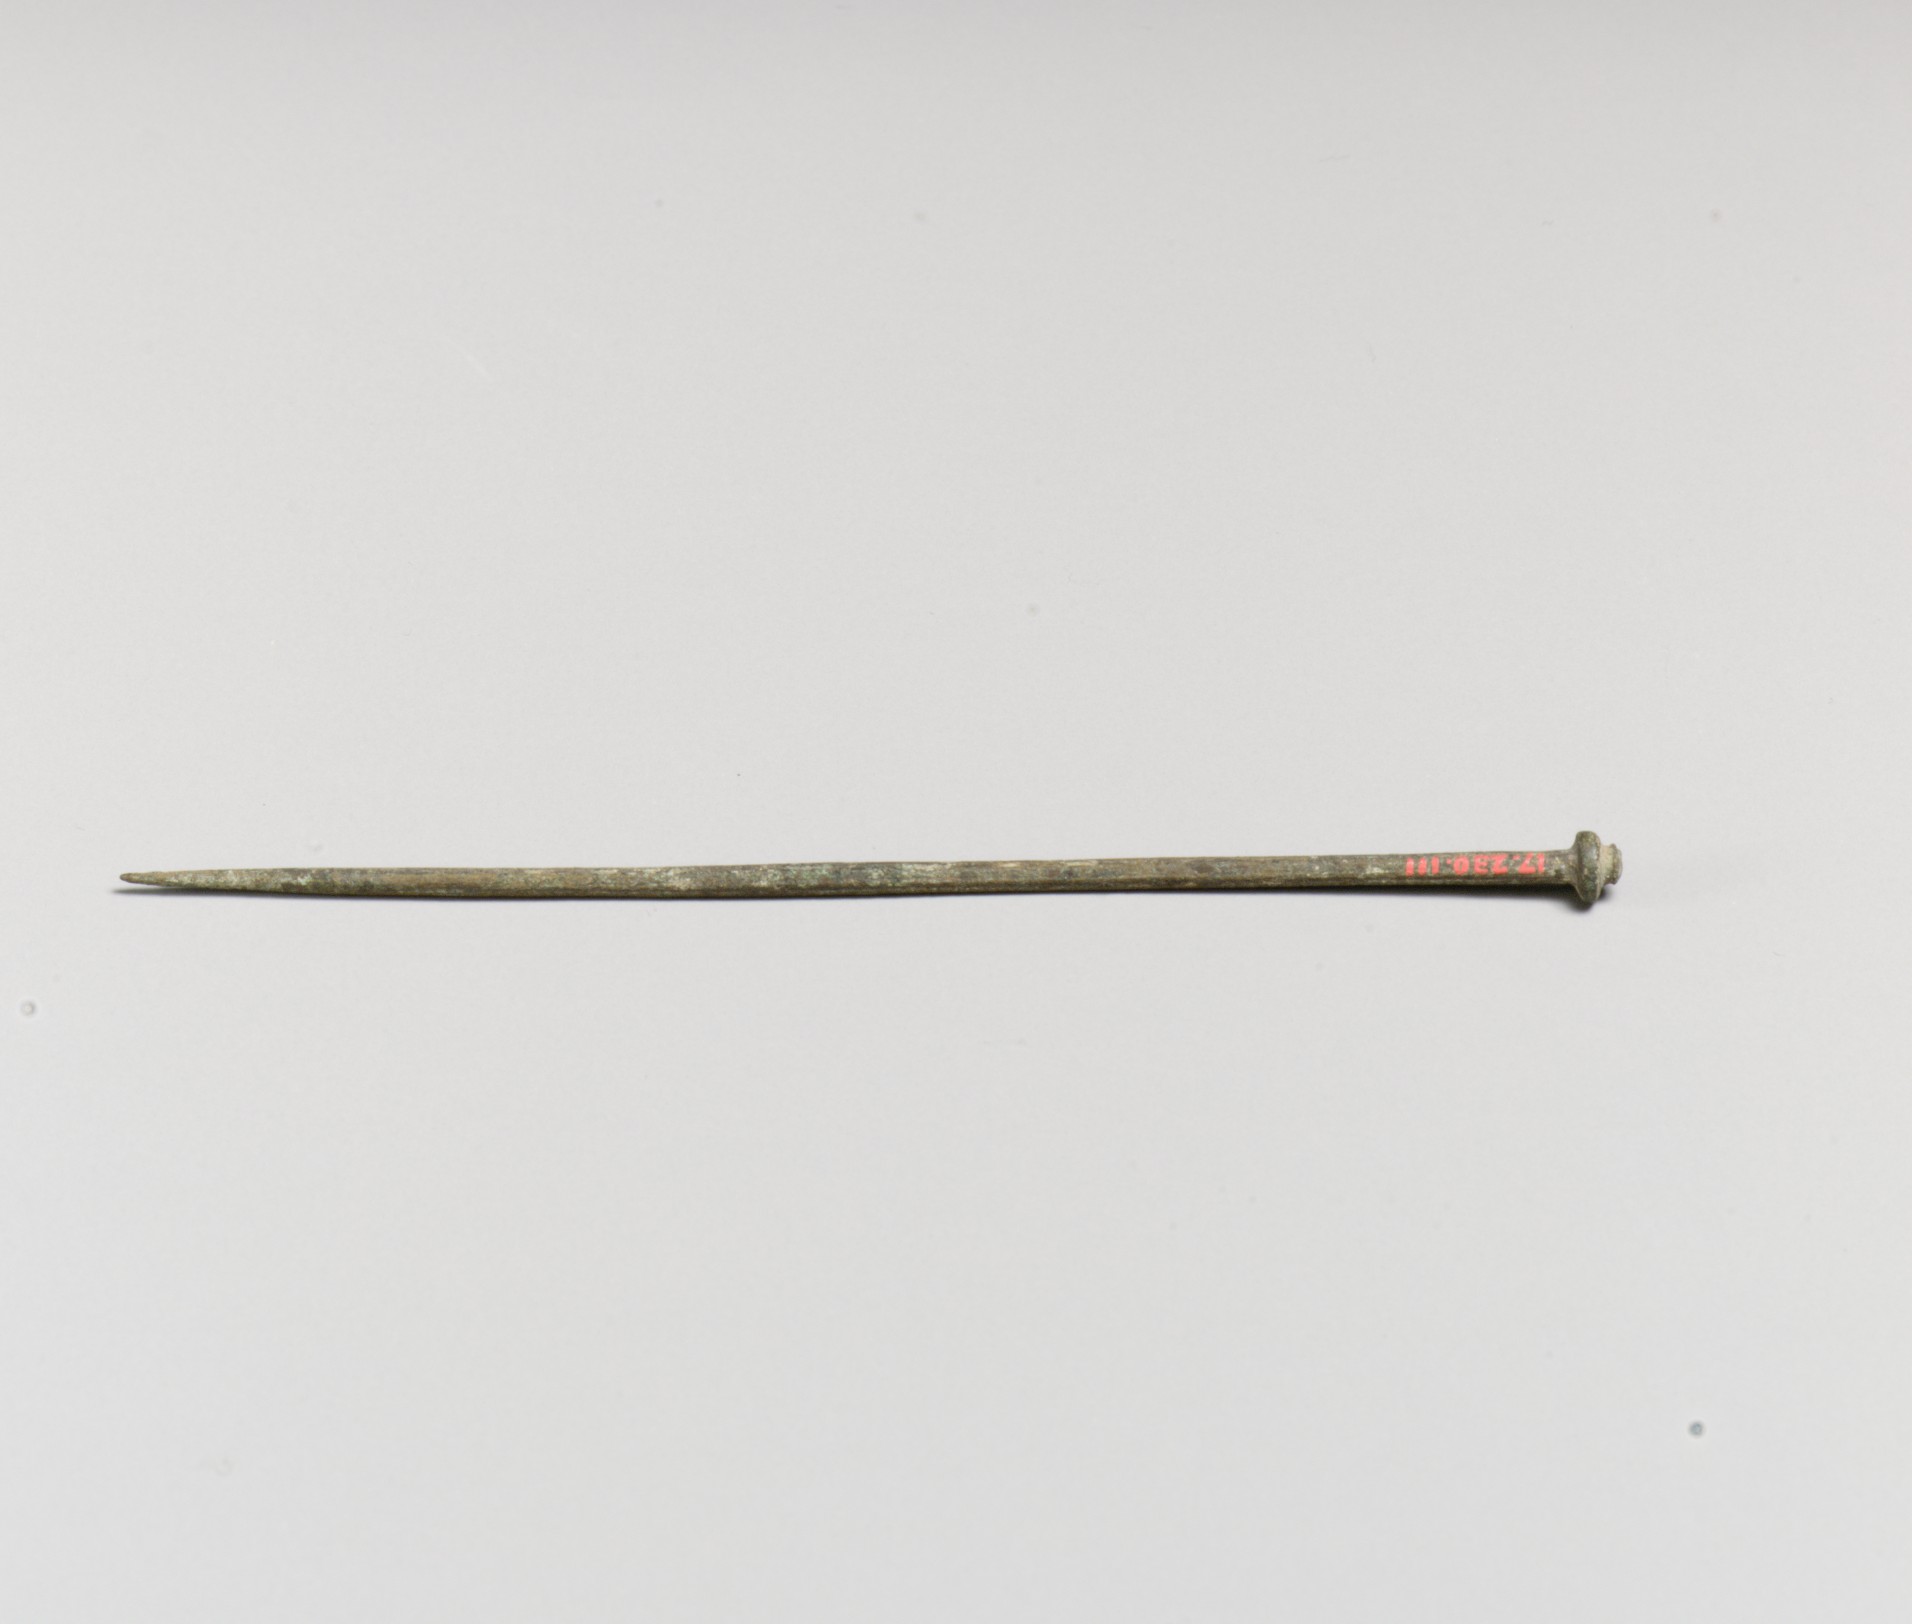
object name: pin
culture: roman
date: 670 BCE-330 CE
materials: bronze